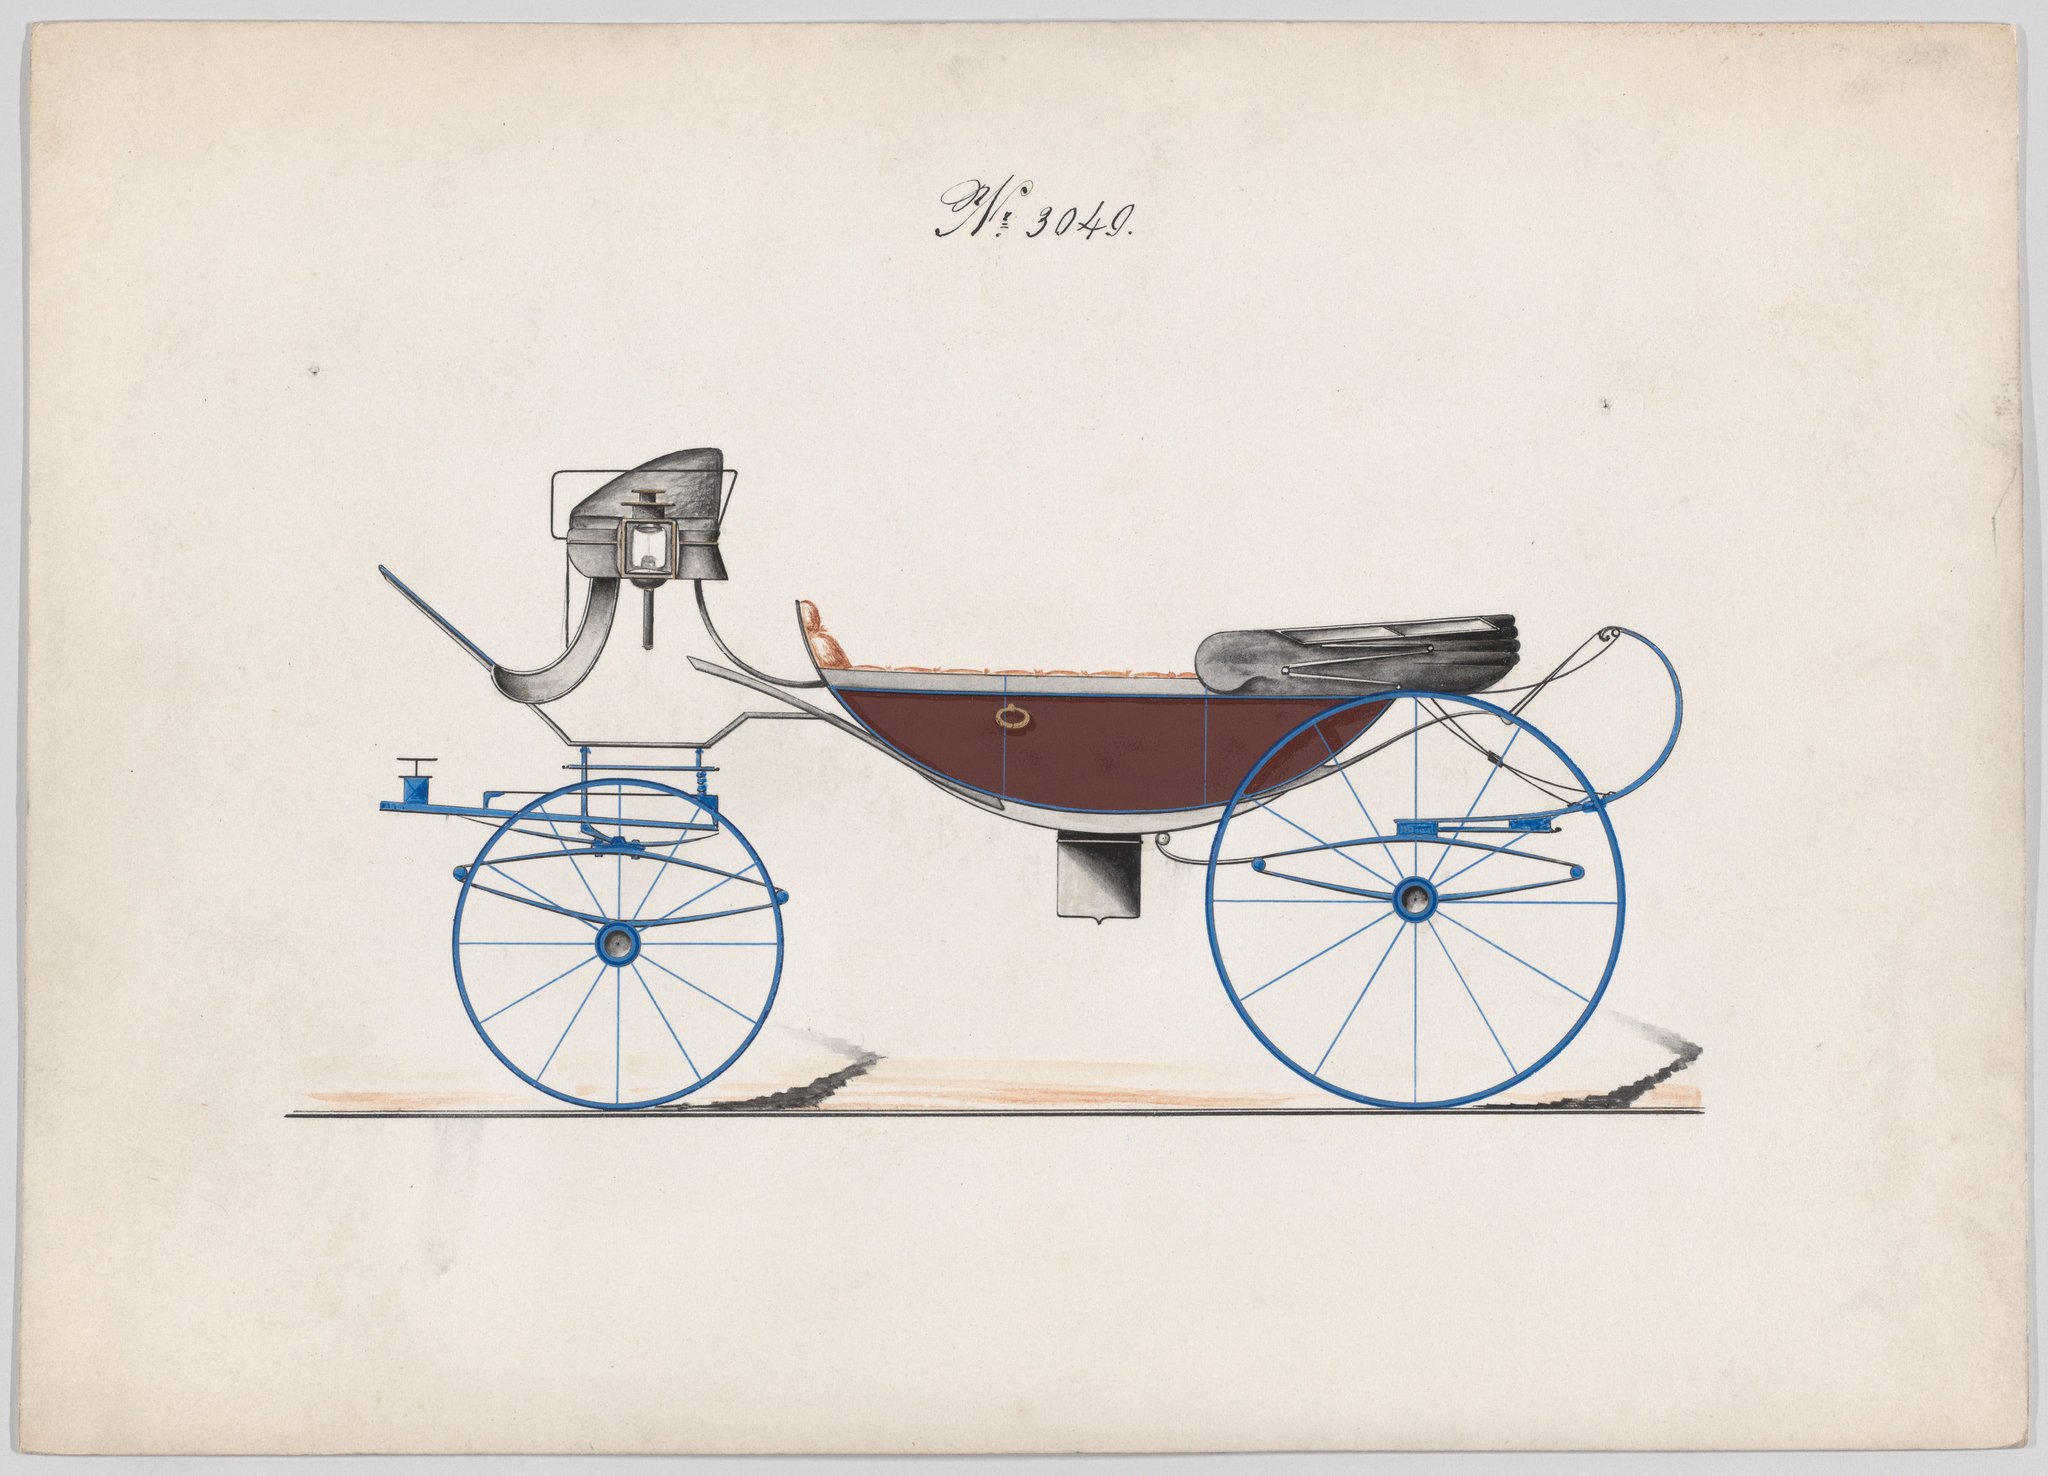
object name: drawing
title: Vis-à-vis #3049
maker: brewster & co.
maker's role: manufacturer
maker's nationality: american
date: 1874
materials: gouache, gum arabic, ink, watercolor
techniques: pen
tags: carriages